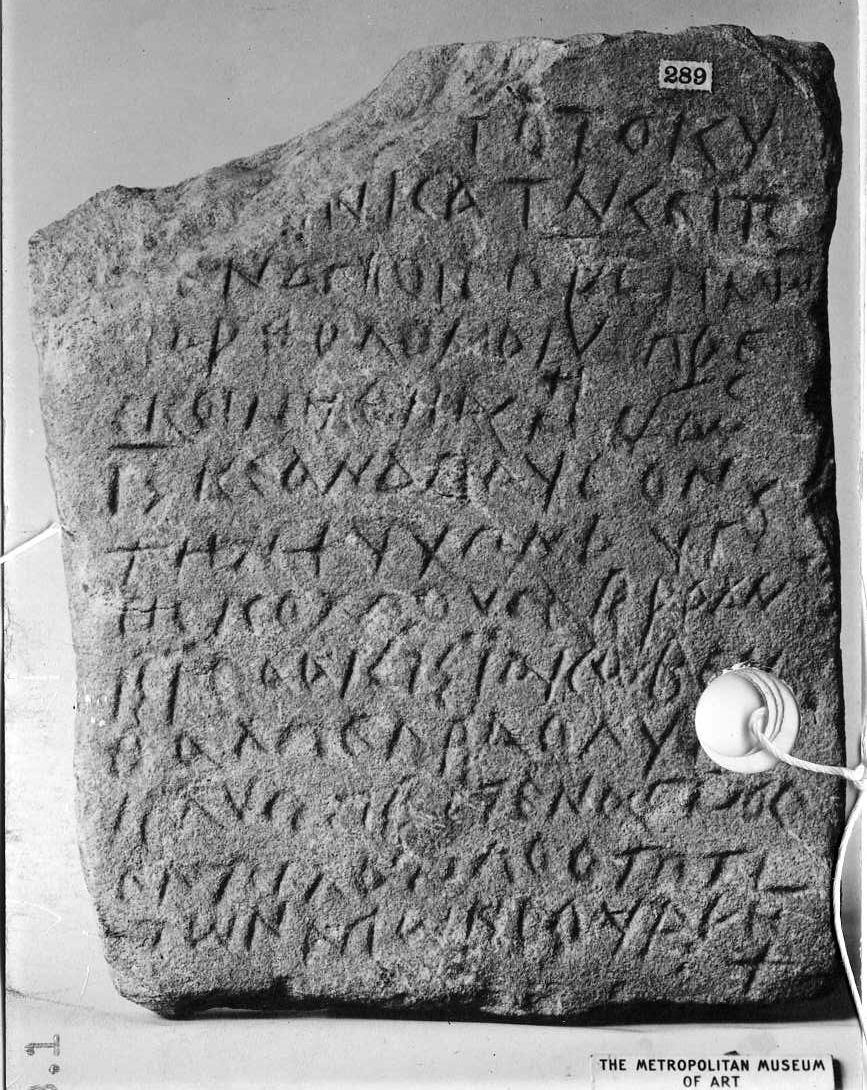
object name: stele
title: Inscribed Stele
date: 601-700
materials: stone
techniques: incising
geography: egypt